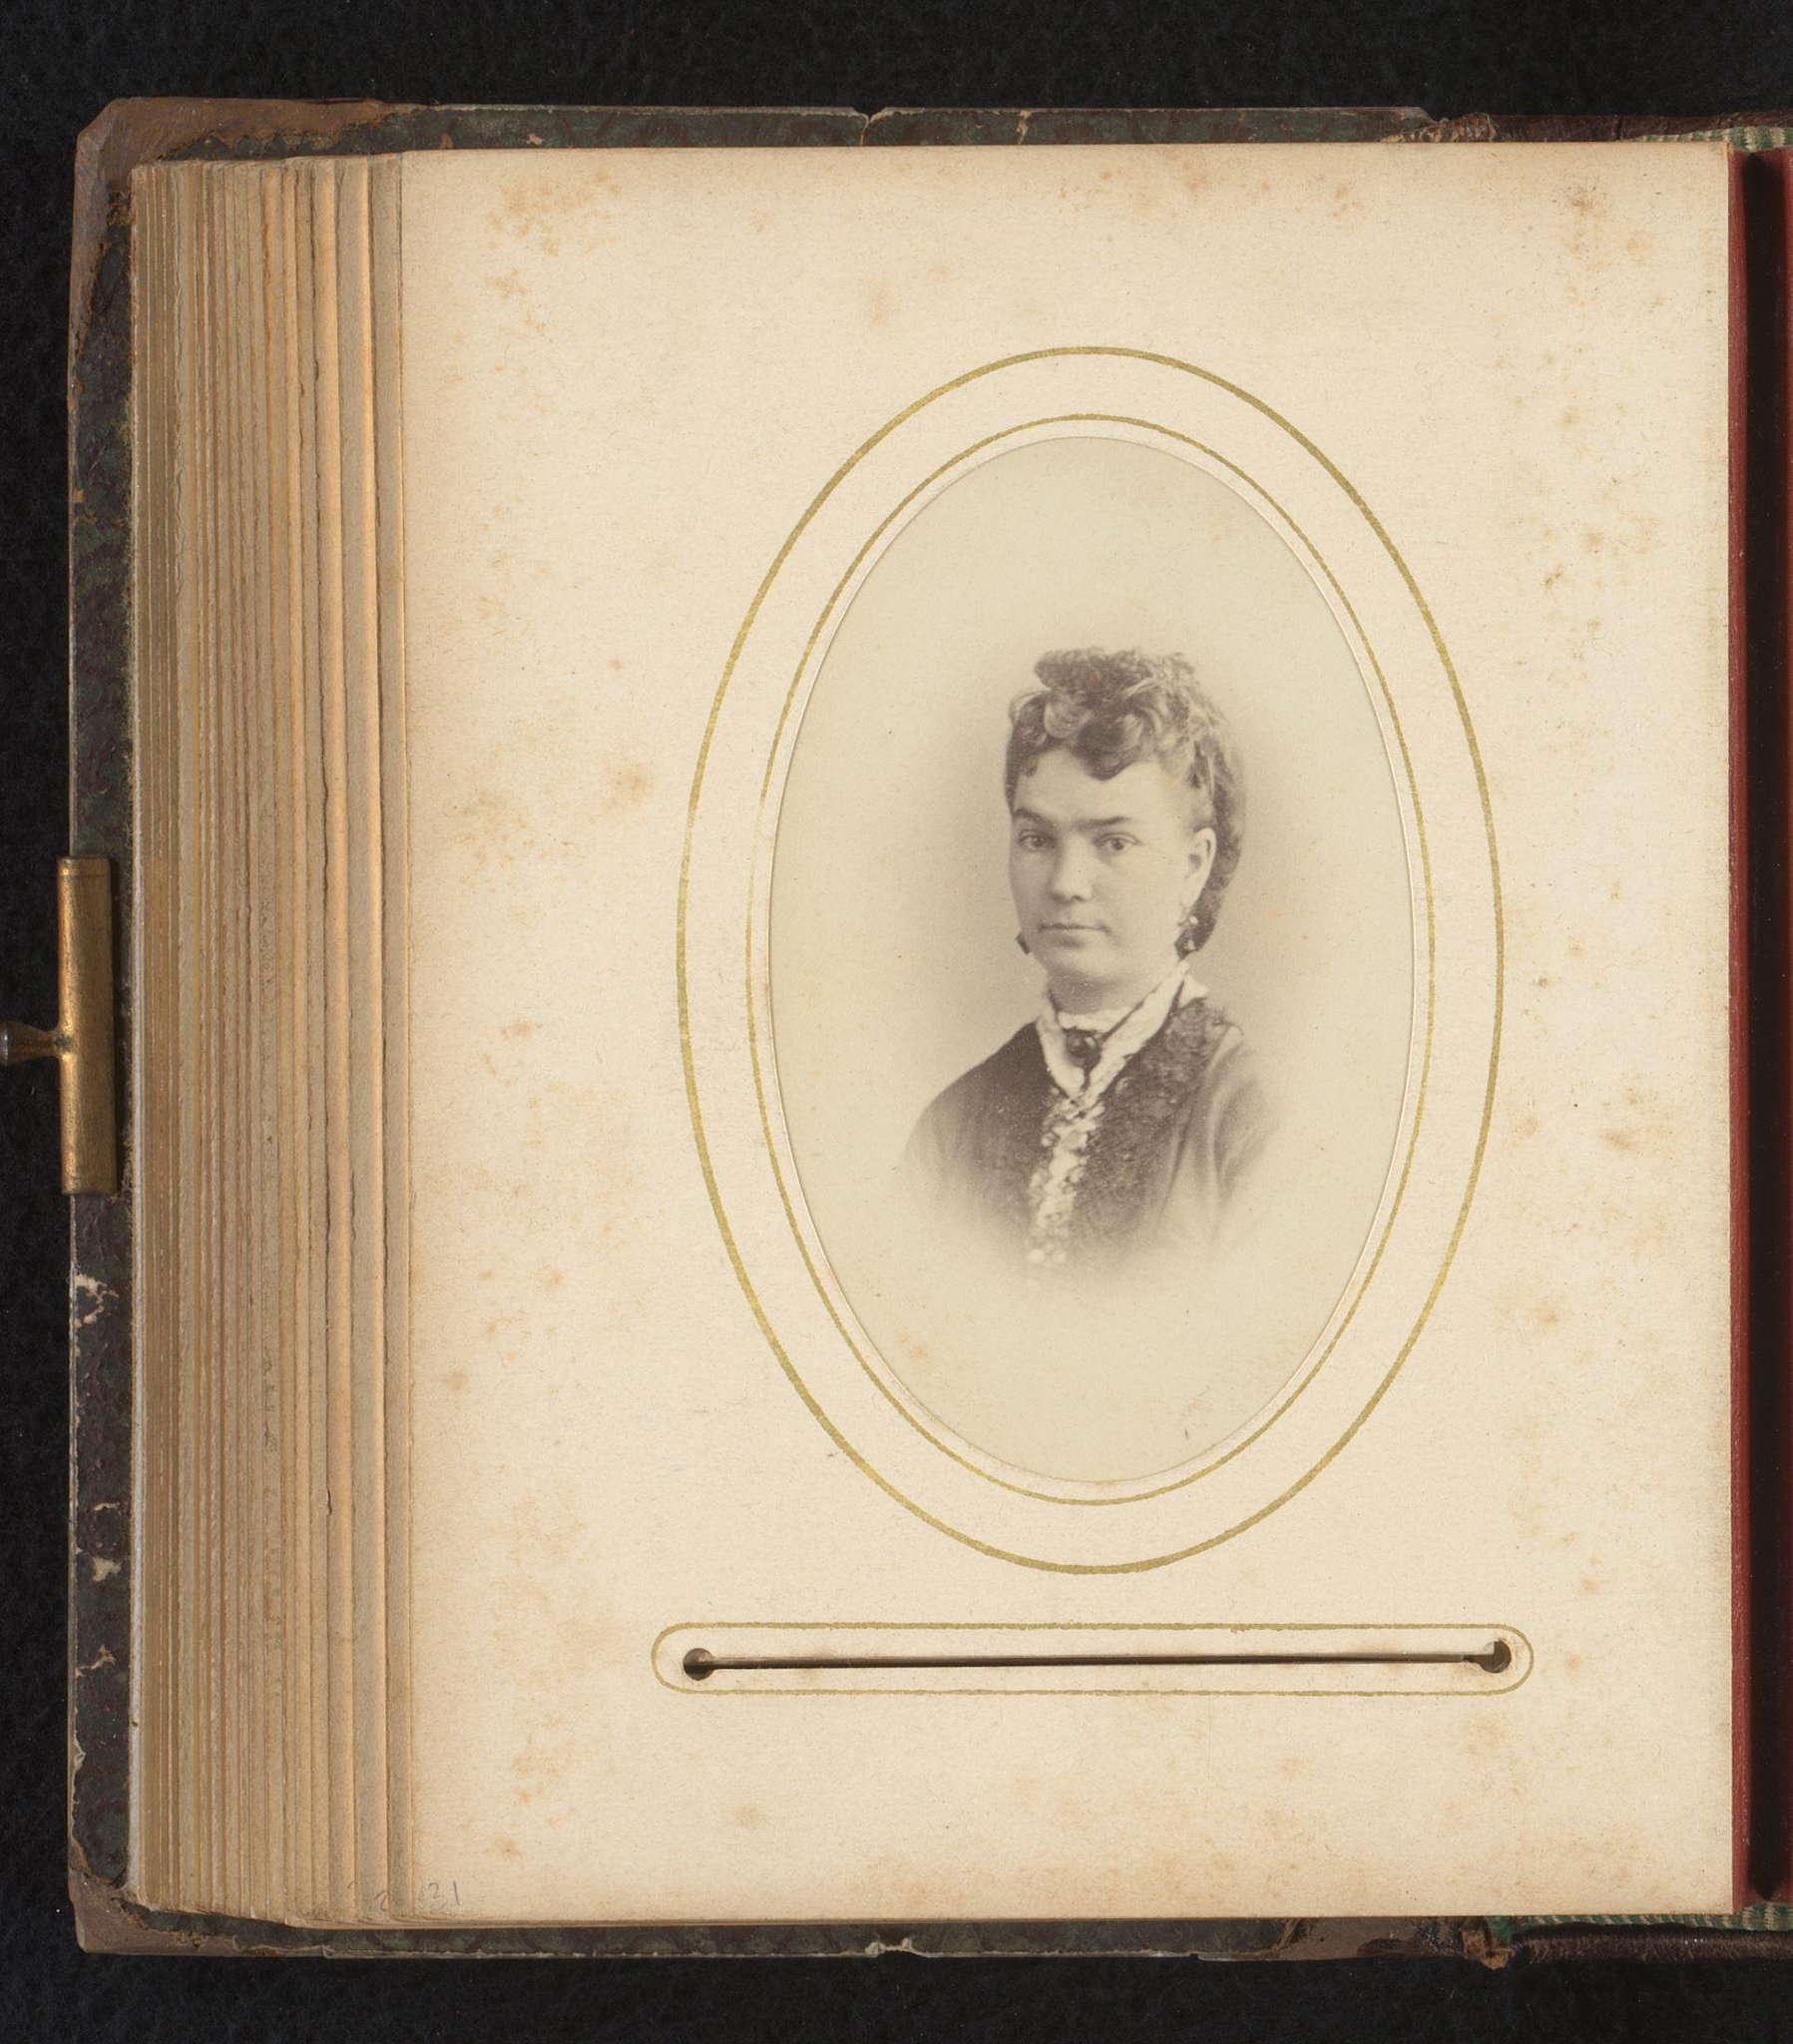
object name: photograph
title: Portret van een jonge vrouw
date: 1860-1900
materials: cardboard, photographic support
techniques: albumen print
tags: adolescent, young woman, maiden, historical persons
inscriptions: inscription: ‘Sala & Irmão/ Premiados nas Exposiçoes/ Industrial de 1861 & Internacional de 1865/ 95, Rua do Bomjardin/ Porto (...)’